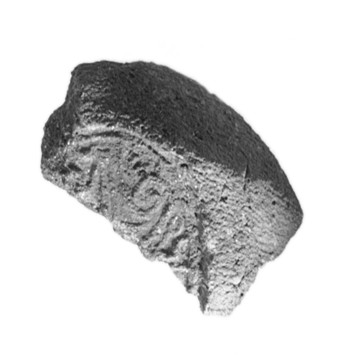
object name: sealing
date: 2030-1640 BCE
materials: clay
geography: egypt